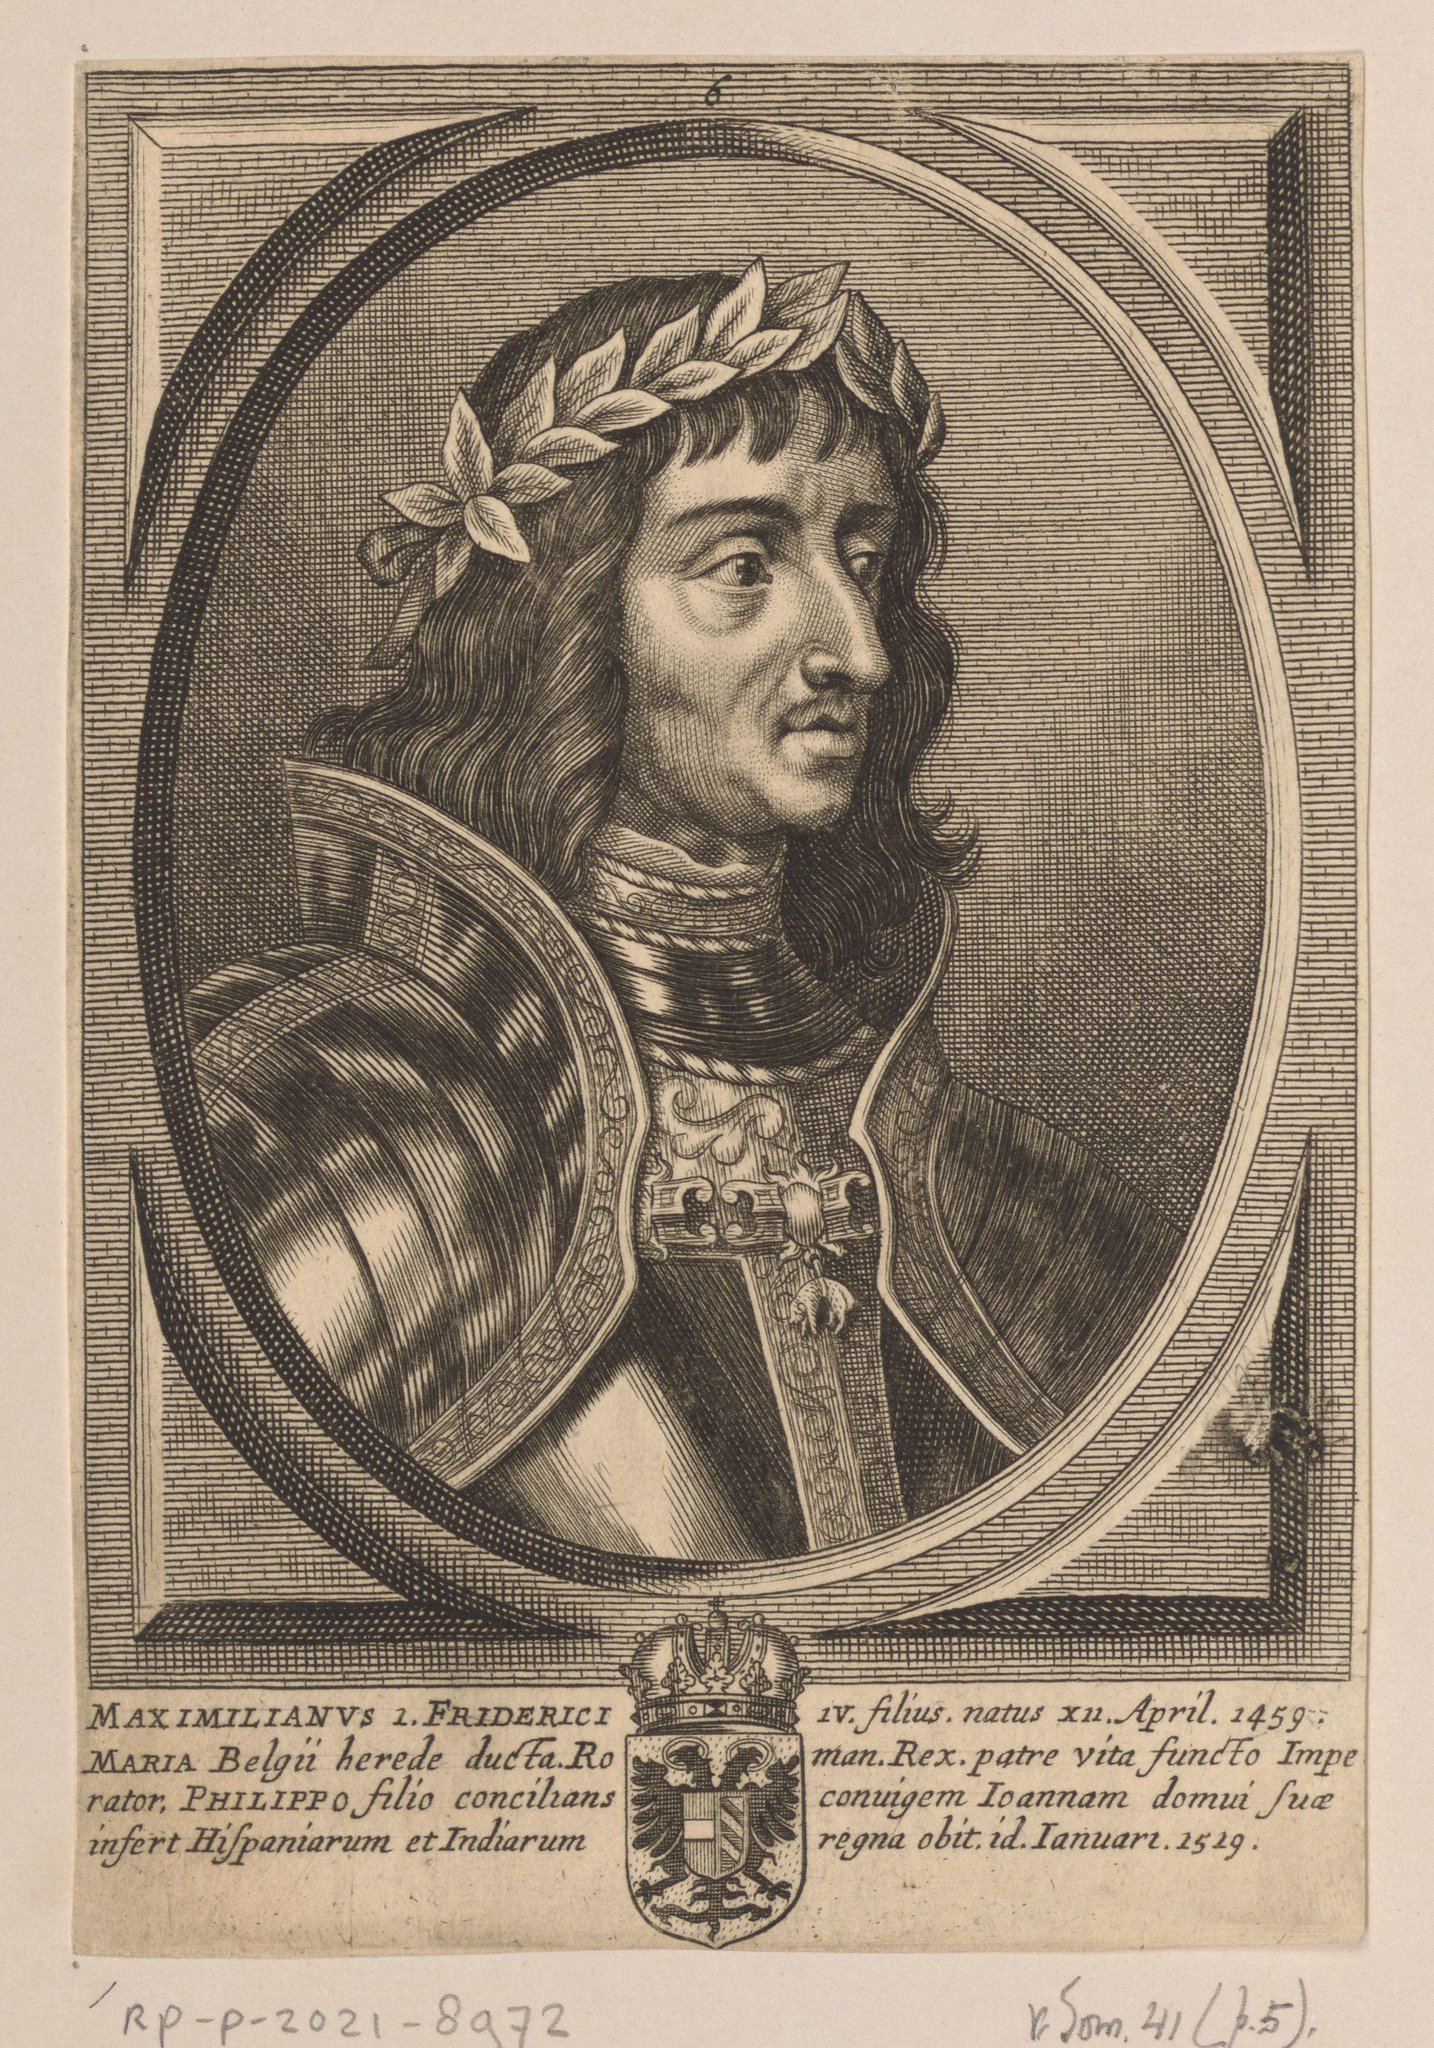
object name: print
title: Portretten van Oostenrijkse keizers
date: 1637-1670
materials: paper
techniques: engraving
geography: antwerp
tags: maximilian i (holy roman emperor), ornament ~ medallion, armour, historical persons, knighthood order of the golden fleece - insignia of a knighthood order, e.g.: badge, chain (with name of order), armorial bearing, heraldry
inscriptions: number: ‘No. 1176/ 16’